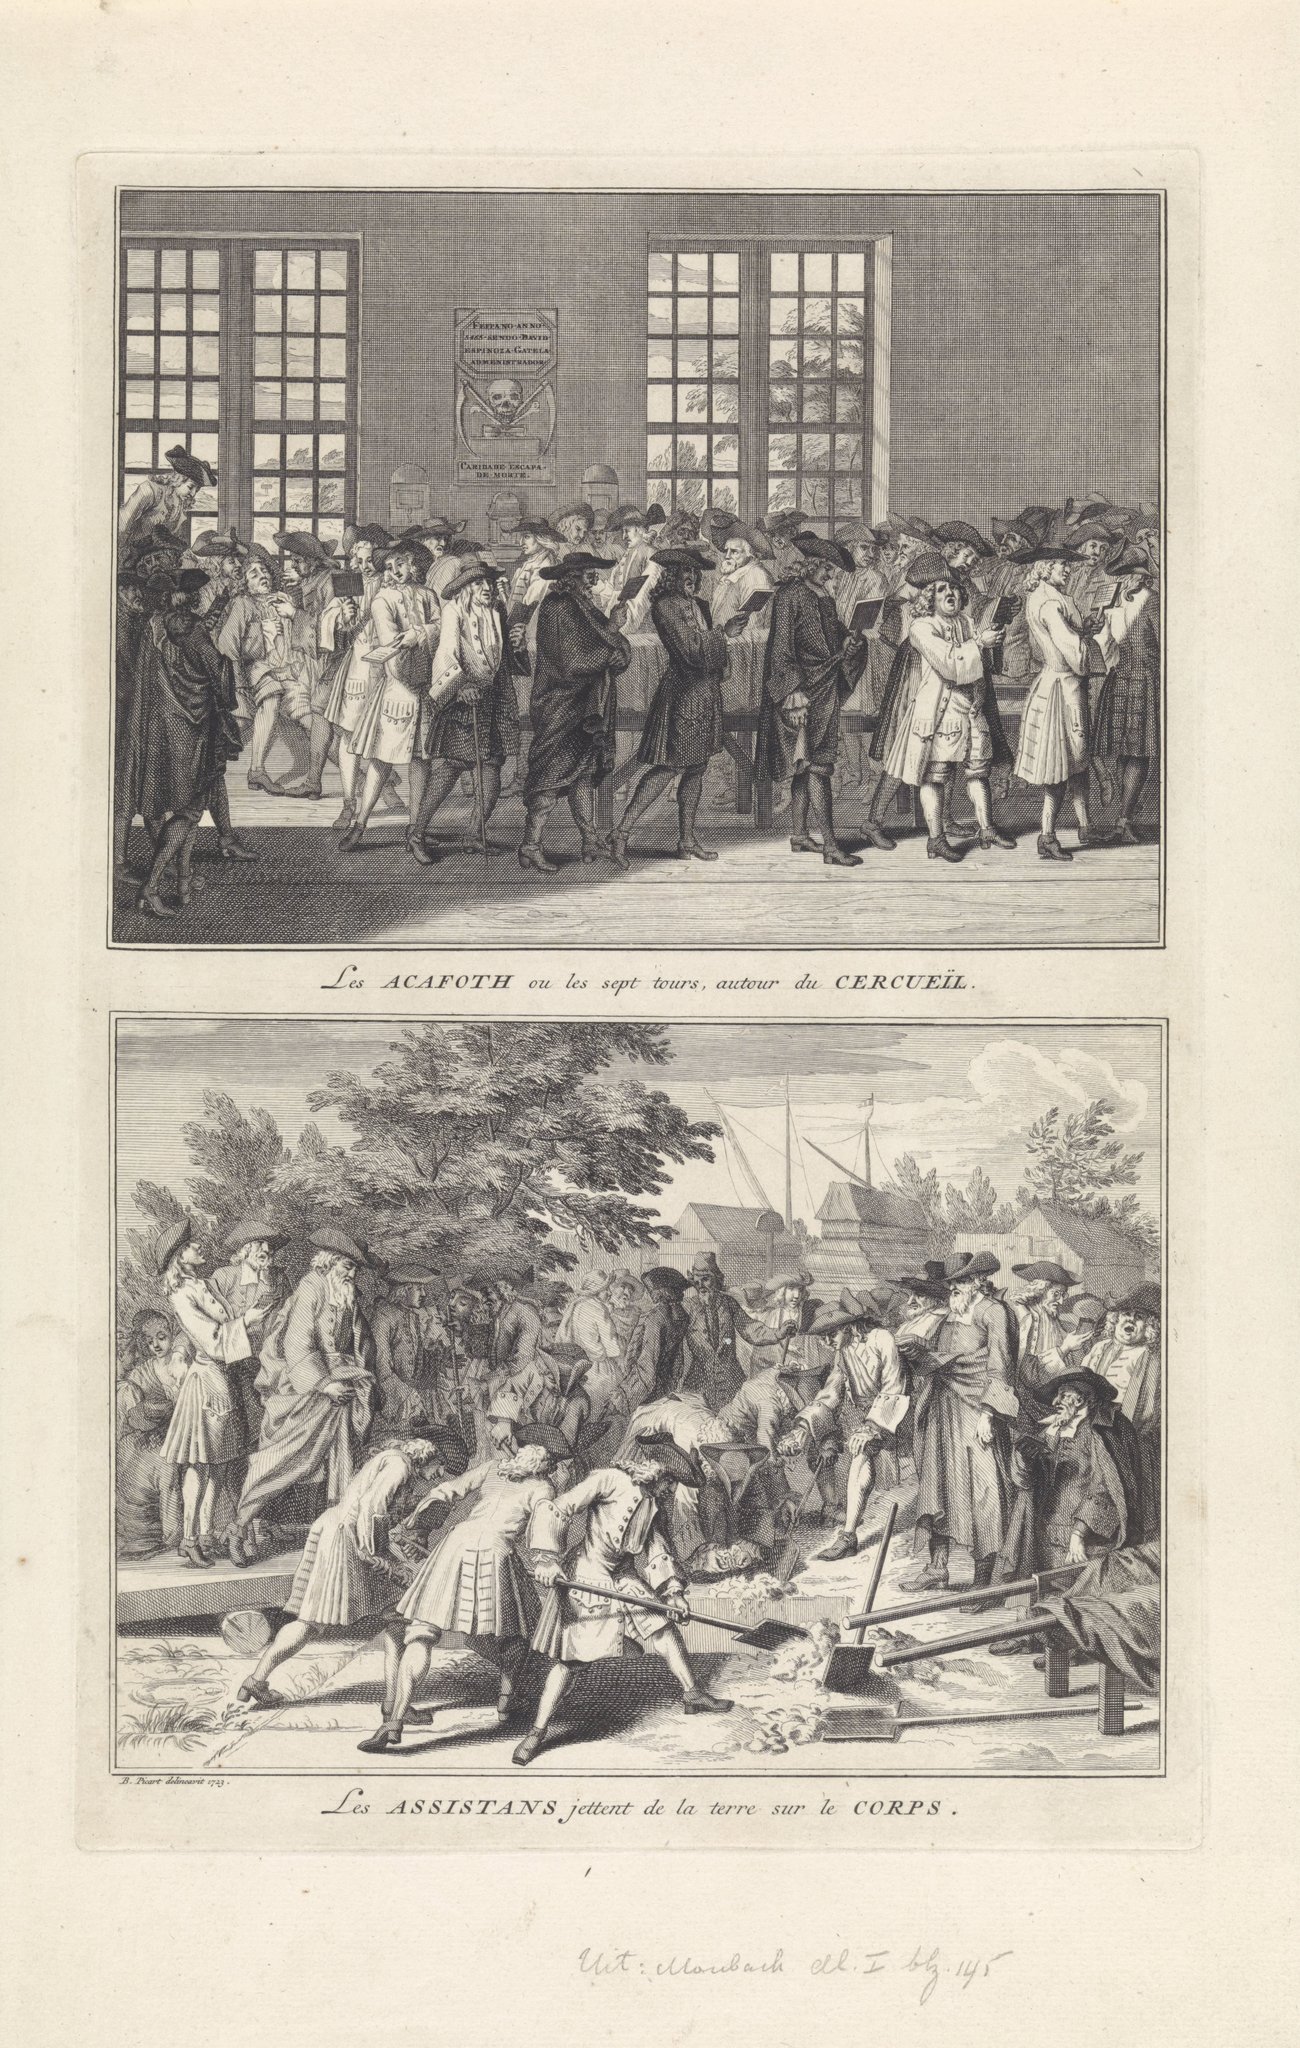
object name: print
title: Les Acafoth ou les sept tours, autour du Cercueïl / Les Assistans jettent de la terre sur le Corps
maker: bernard picart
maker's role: draughtsman, print maker, publisher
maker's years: 1673-1733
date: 1723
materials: paper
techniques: engraving, etching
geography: amsterdam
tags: death and burial ~ jewish customs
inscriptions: collector's mark: Lugt 240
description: Prent gebruikt in en mogelijk gebruikt in andere edities van: Picart, Bernard. Ceremonies et coutumes religieuses de tous les peuples du monde (...). Tome premier, qui contient les ceremonies des juifs & des chrétiens catholiques. Deel 1. Amsterdam: Jean Frederic Bernard, 1723, na p. 148.